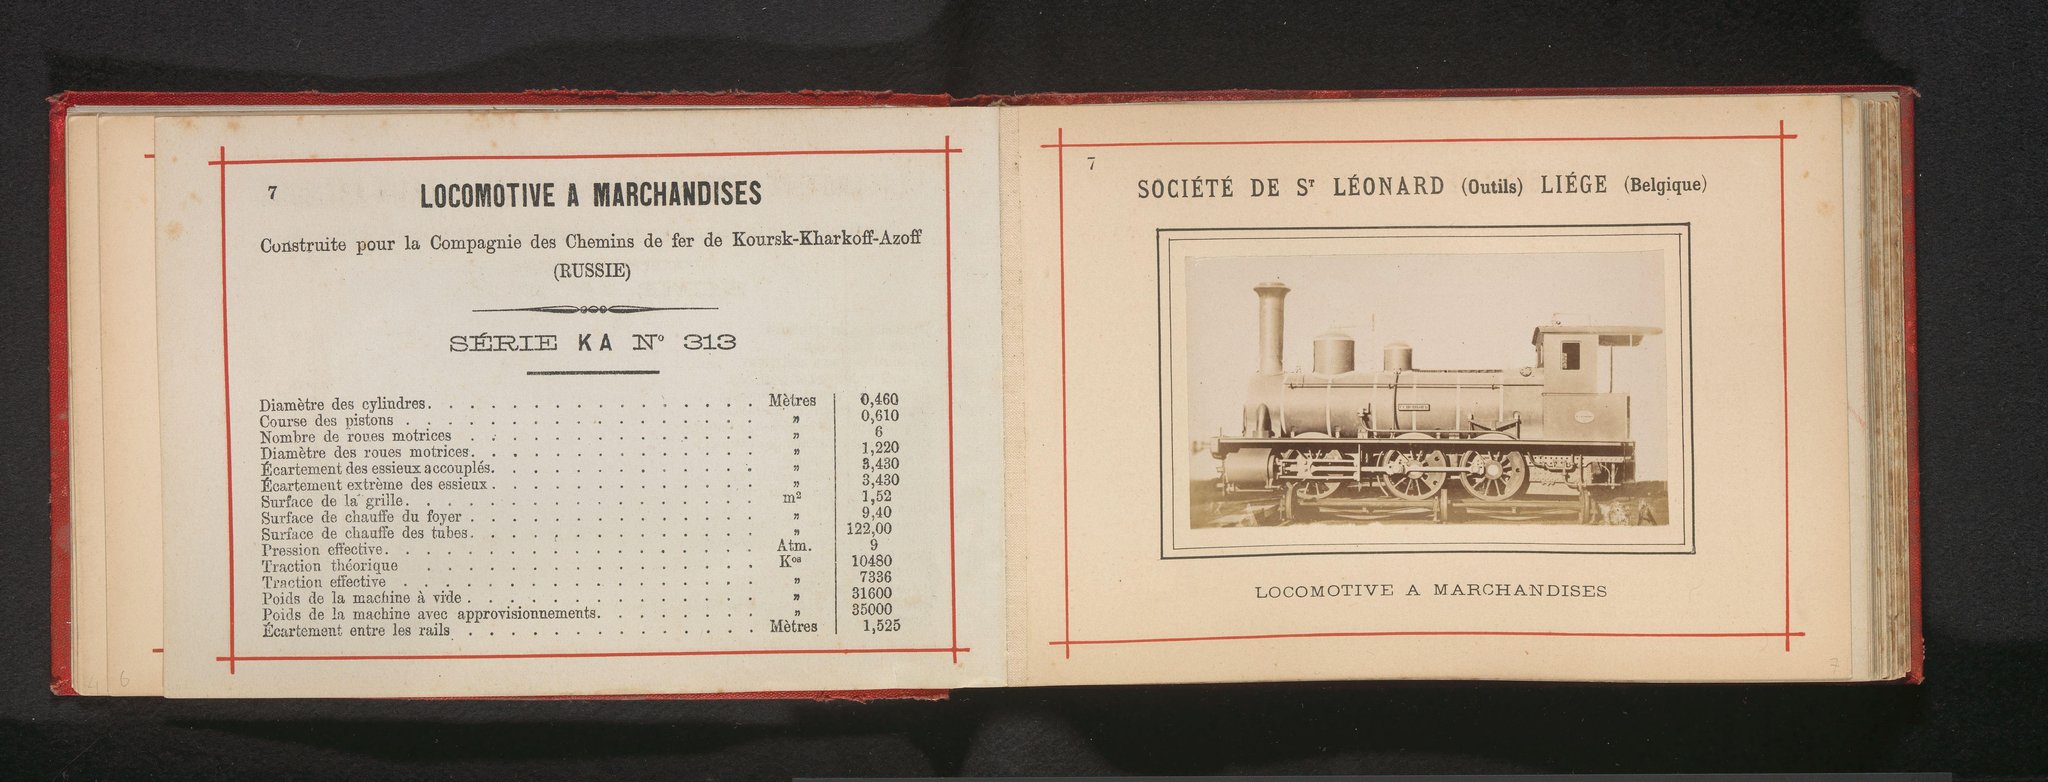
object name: photograph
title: Locomotief voor een goederentrein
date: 1880-1885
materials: photographic support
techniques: albumen print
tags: locomotive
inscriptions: inscription: ‘Société de St. Léonard (Outils) Liége (Belgique)’